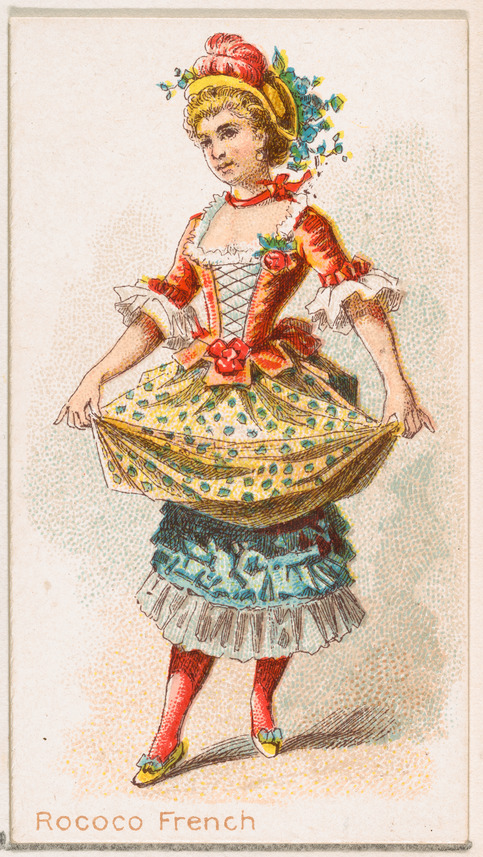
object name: print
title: Rococo French Dancer, from the Dancing Women series (N186) issued by Wm. S. Kimball & Co.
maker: william s. kimball & company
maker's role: publisher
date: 1889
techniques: color lithograph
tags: dance,women,dancers